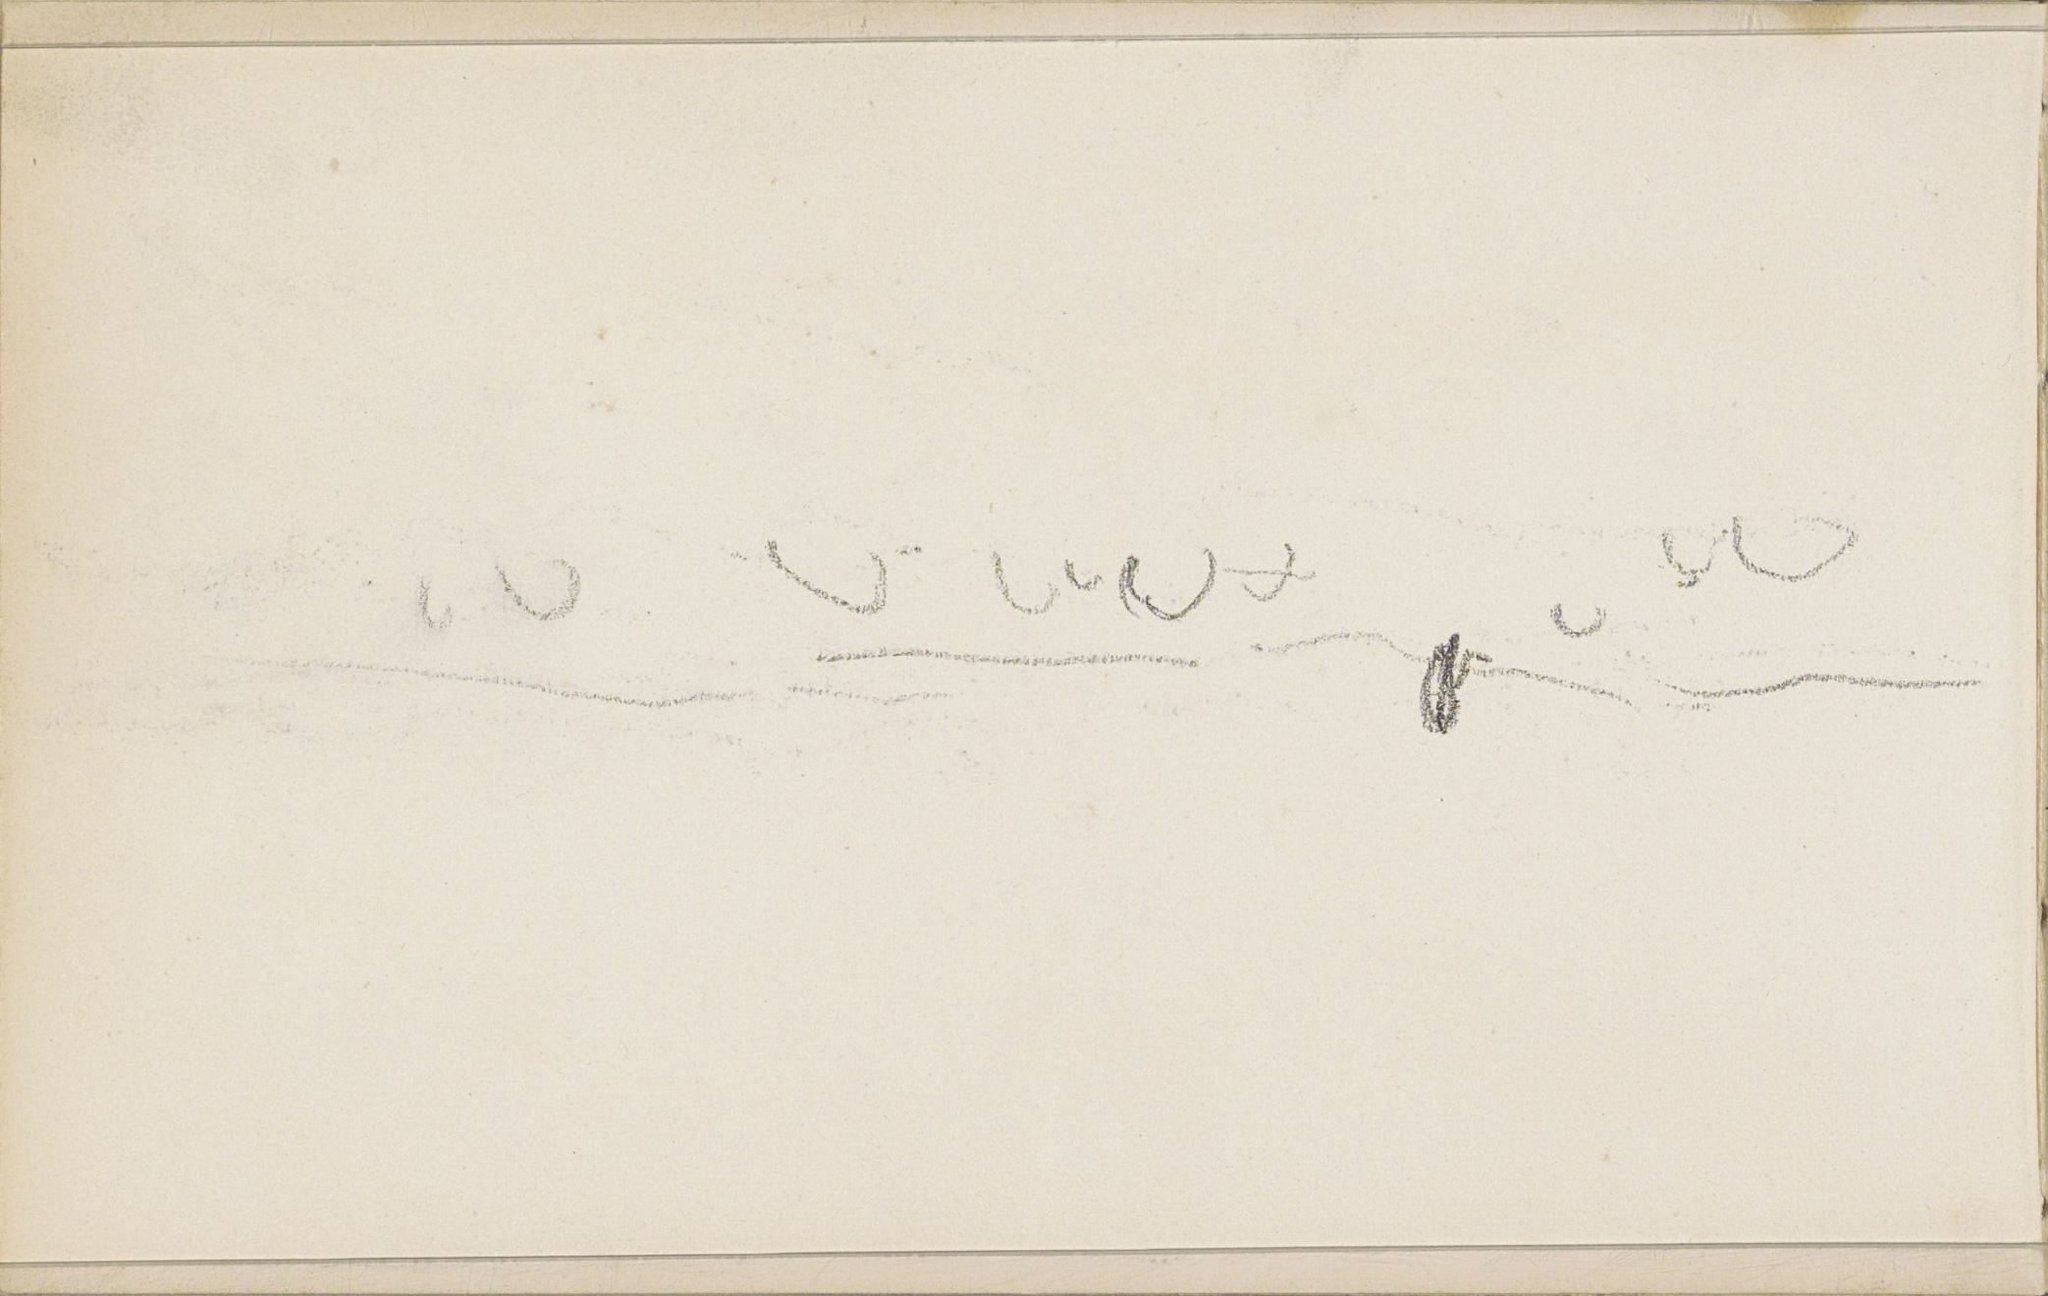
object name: sketchbook leaf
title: Schapen en een figuur in een landschap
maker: anton mauve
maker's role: draughtsman, painter, print maker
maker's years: 1838-1888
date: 1848-1888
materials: paper, pencil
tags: sheep, landscapes (+ landscape with figures, staffage)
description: Blad 19 verso uit een schetsboek met 44 bladen.